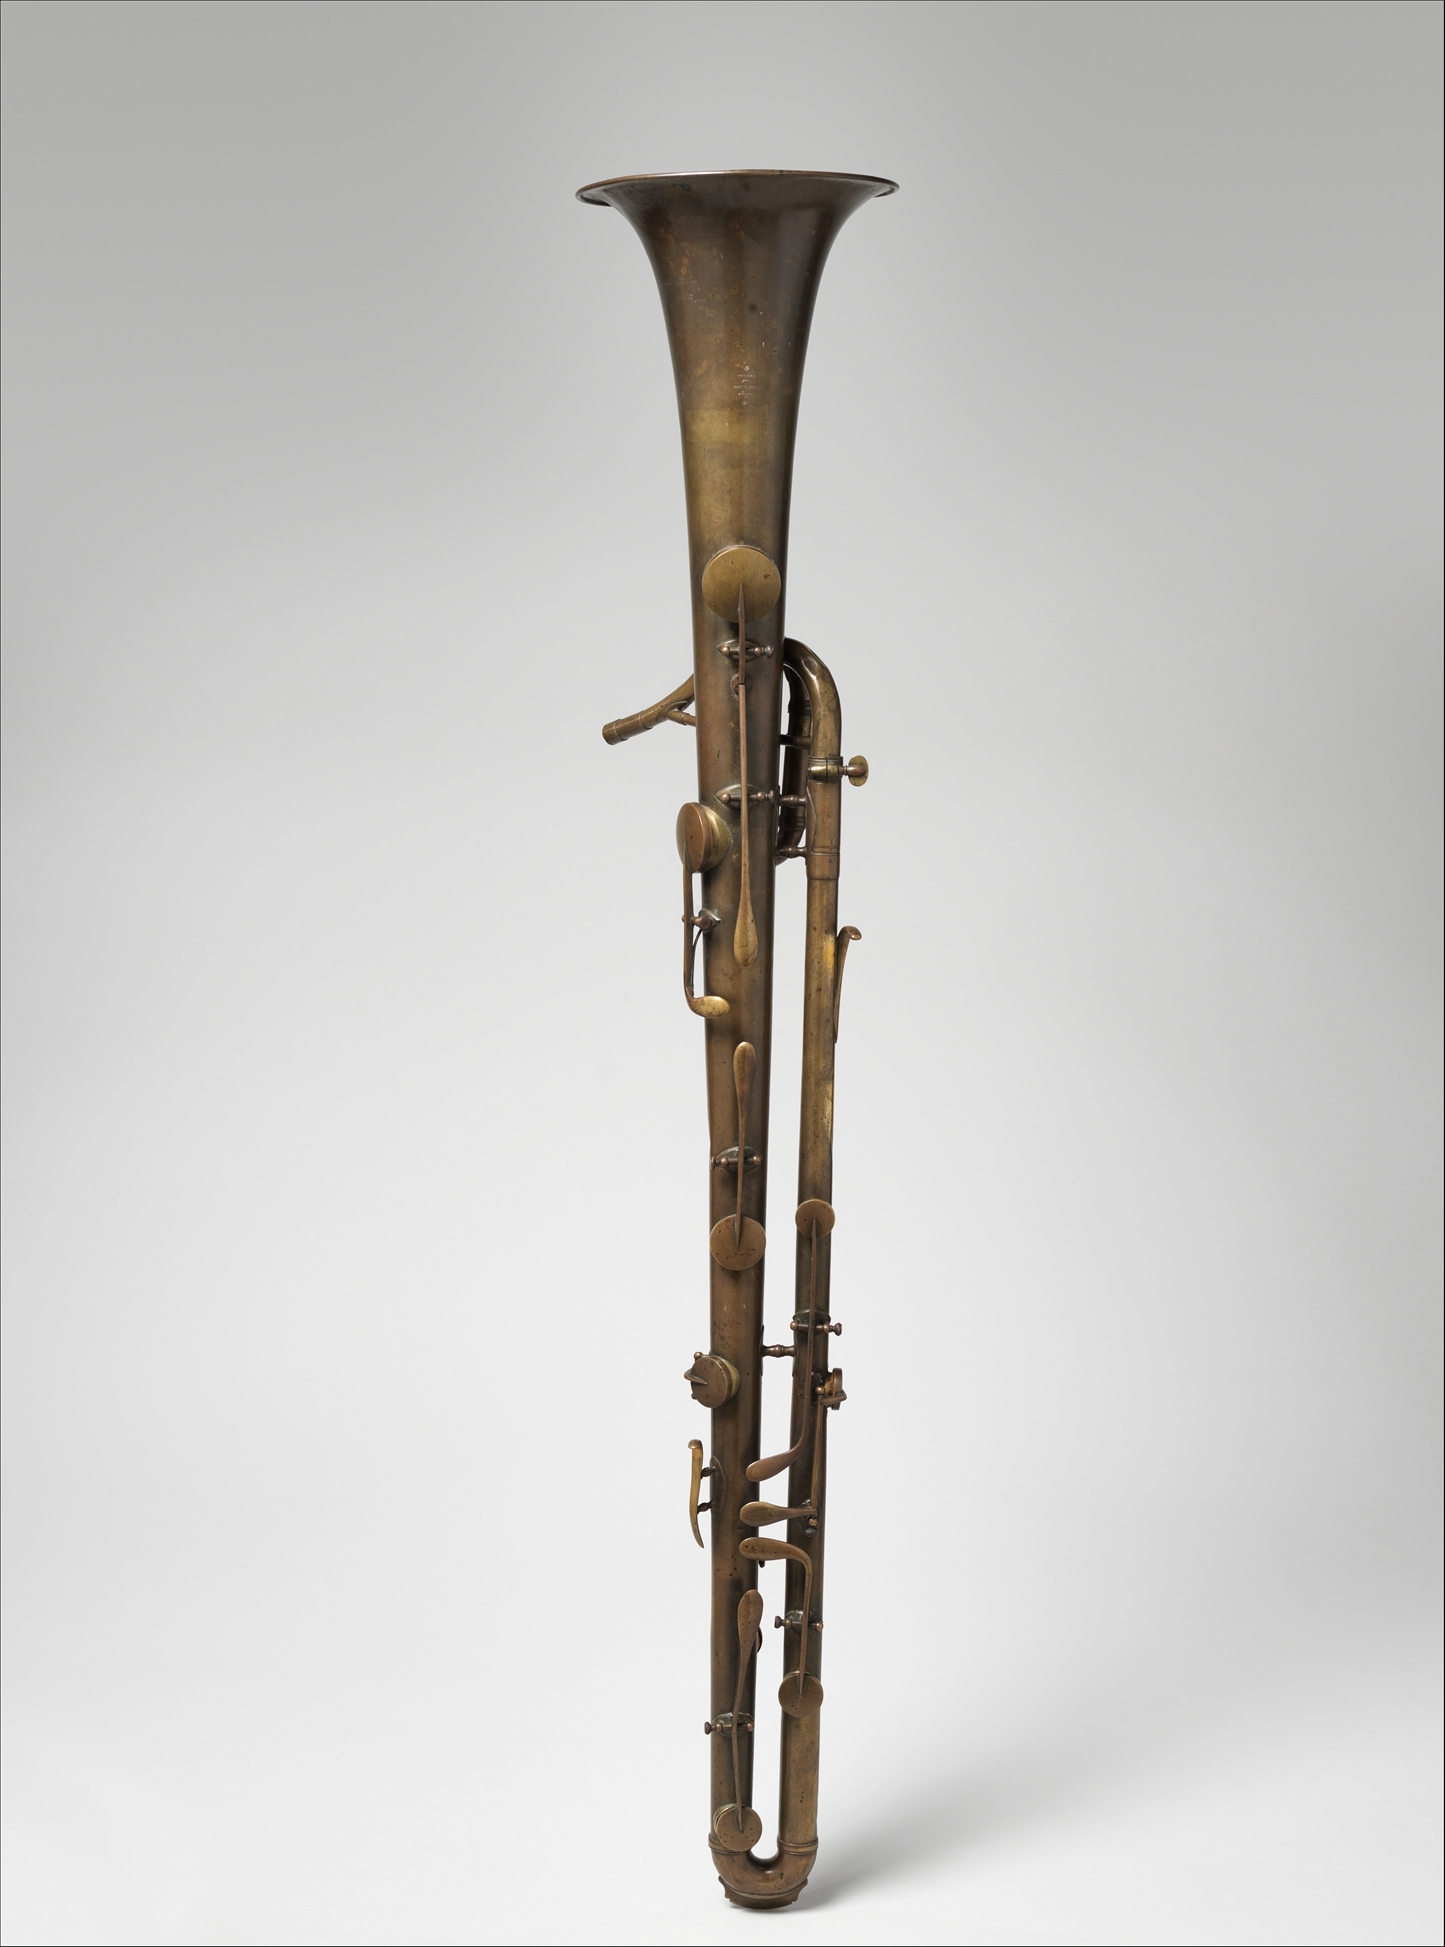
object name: tenor alto ophicleide in e flat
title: Tenor (Alto) Ophicleide in E-flat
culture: french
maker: couturier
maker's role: maker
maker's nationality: french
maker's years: 1812-1900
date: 1830-1850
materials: brass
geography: france